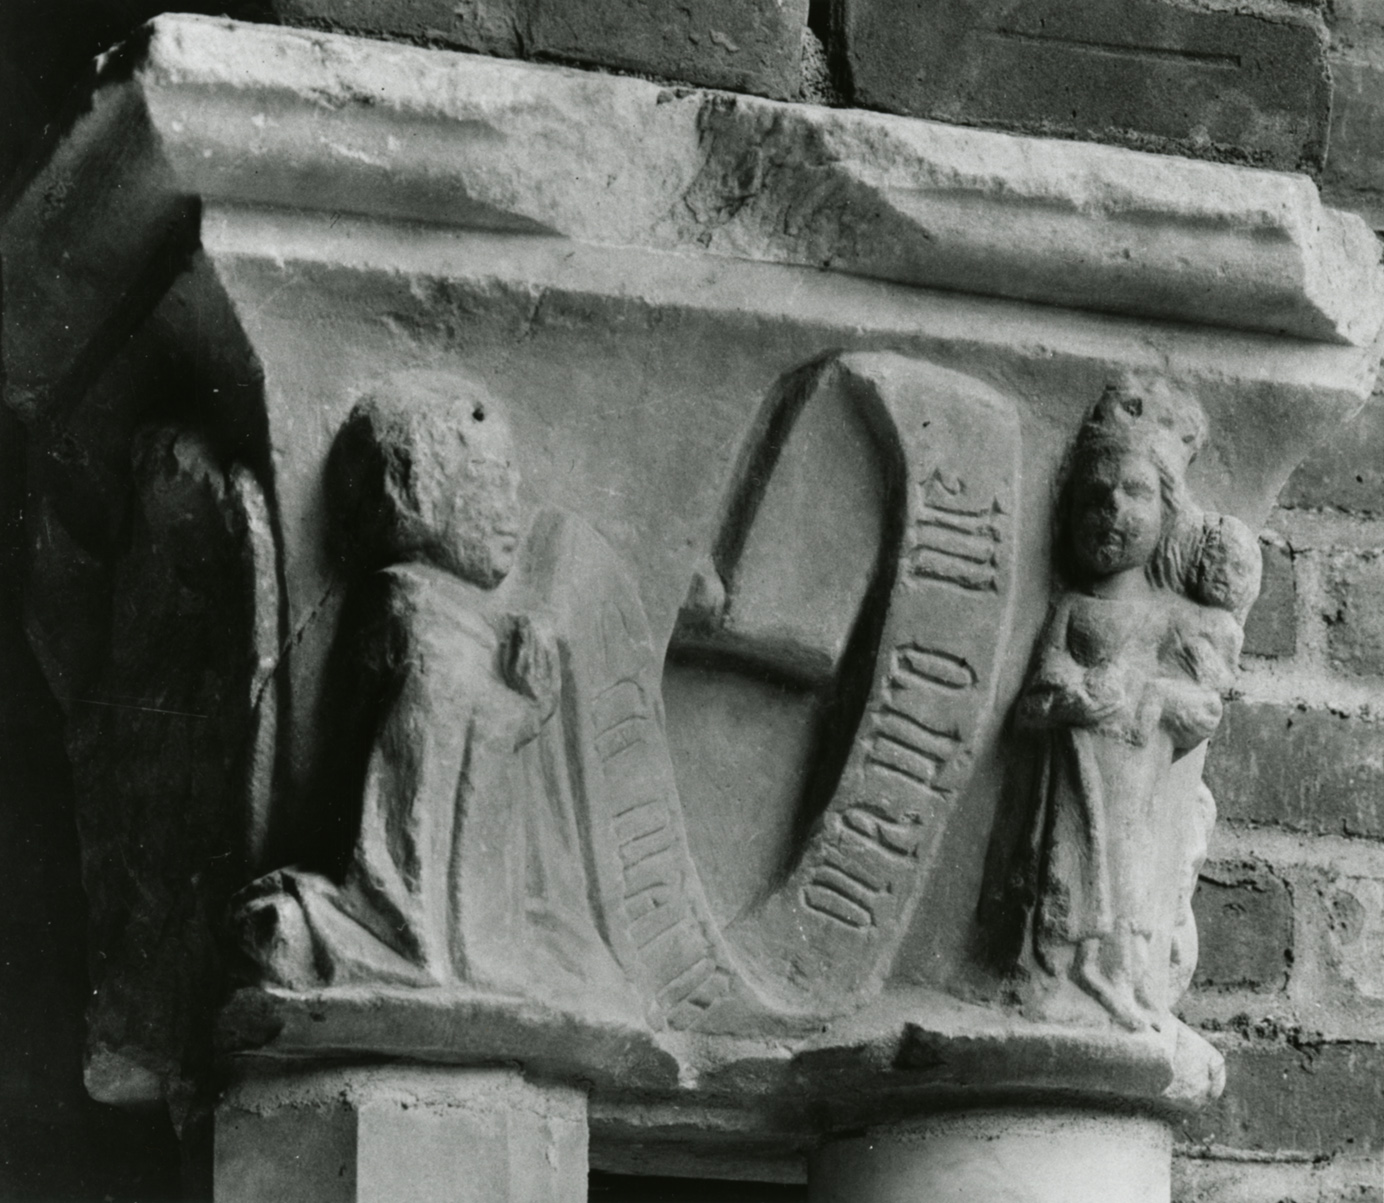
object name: capital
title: Engaged Double Capital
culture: french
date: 1467-1500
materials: marble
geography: france